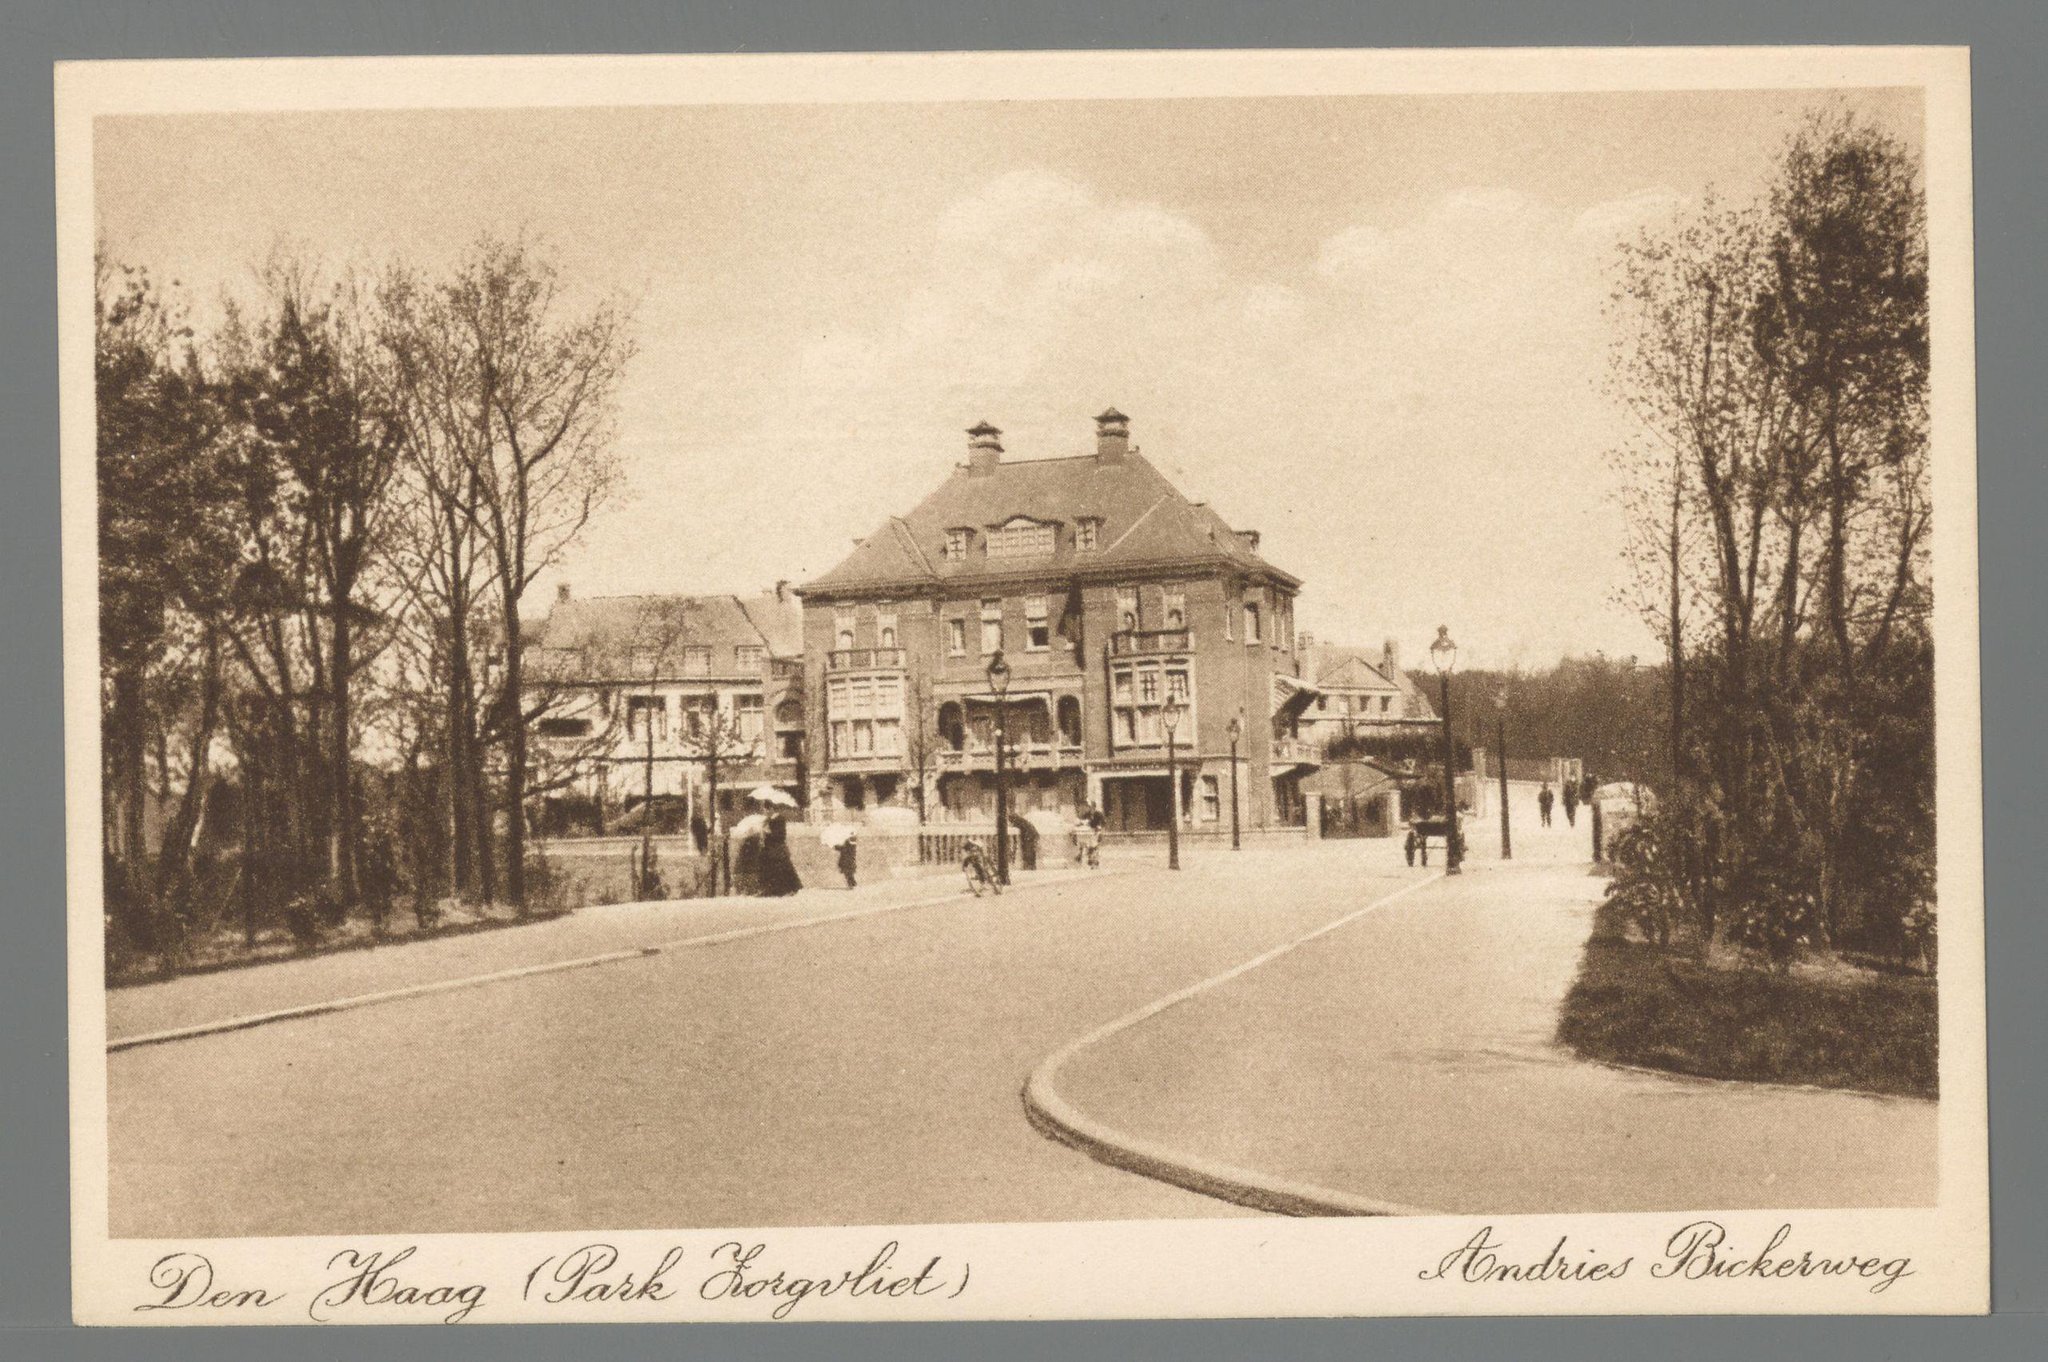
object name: ansichtkaart, prentbriefkaart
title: Andries Bickerweg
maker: Anonymous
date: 1913-1930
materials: cardboard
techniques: rotogravure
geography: the hague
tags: park, villa, street